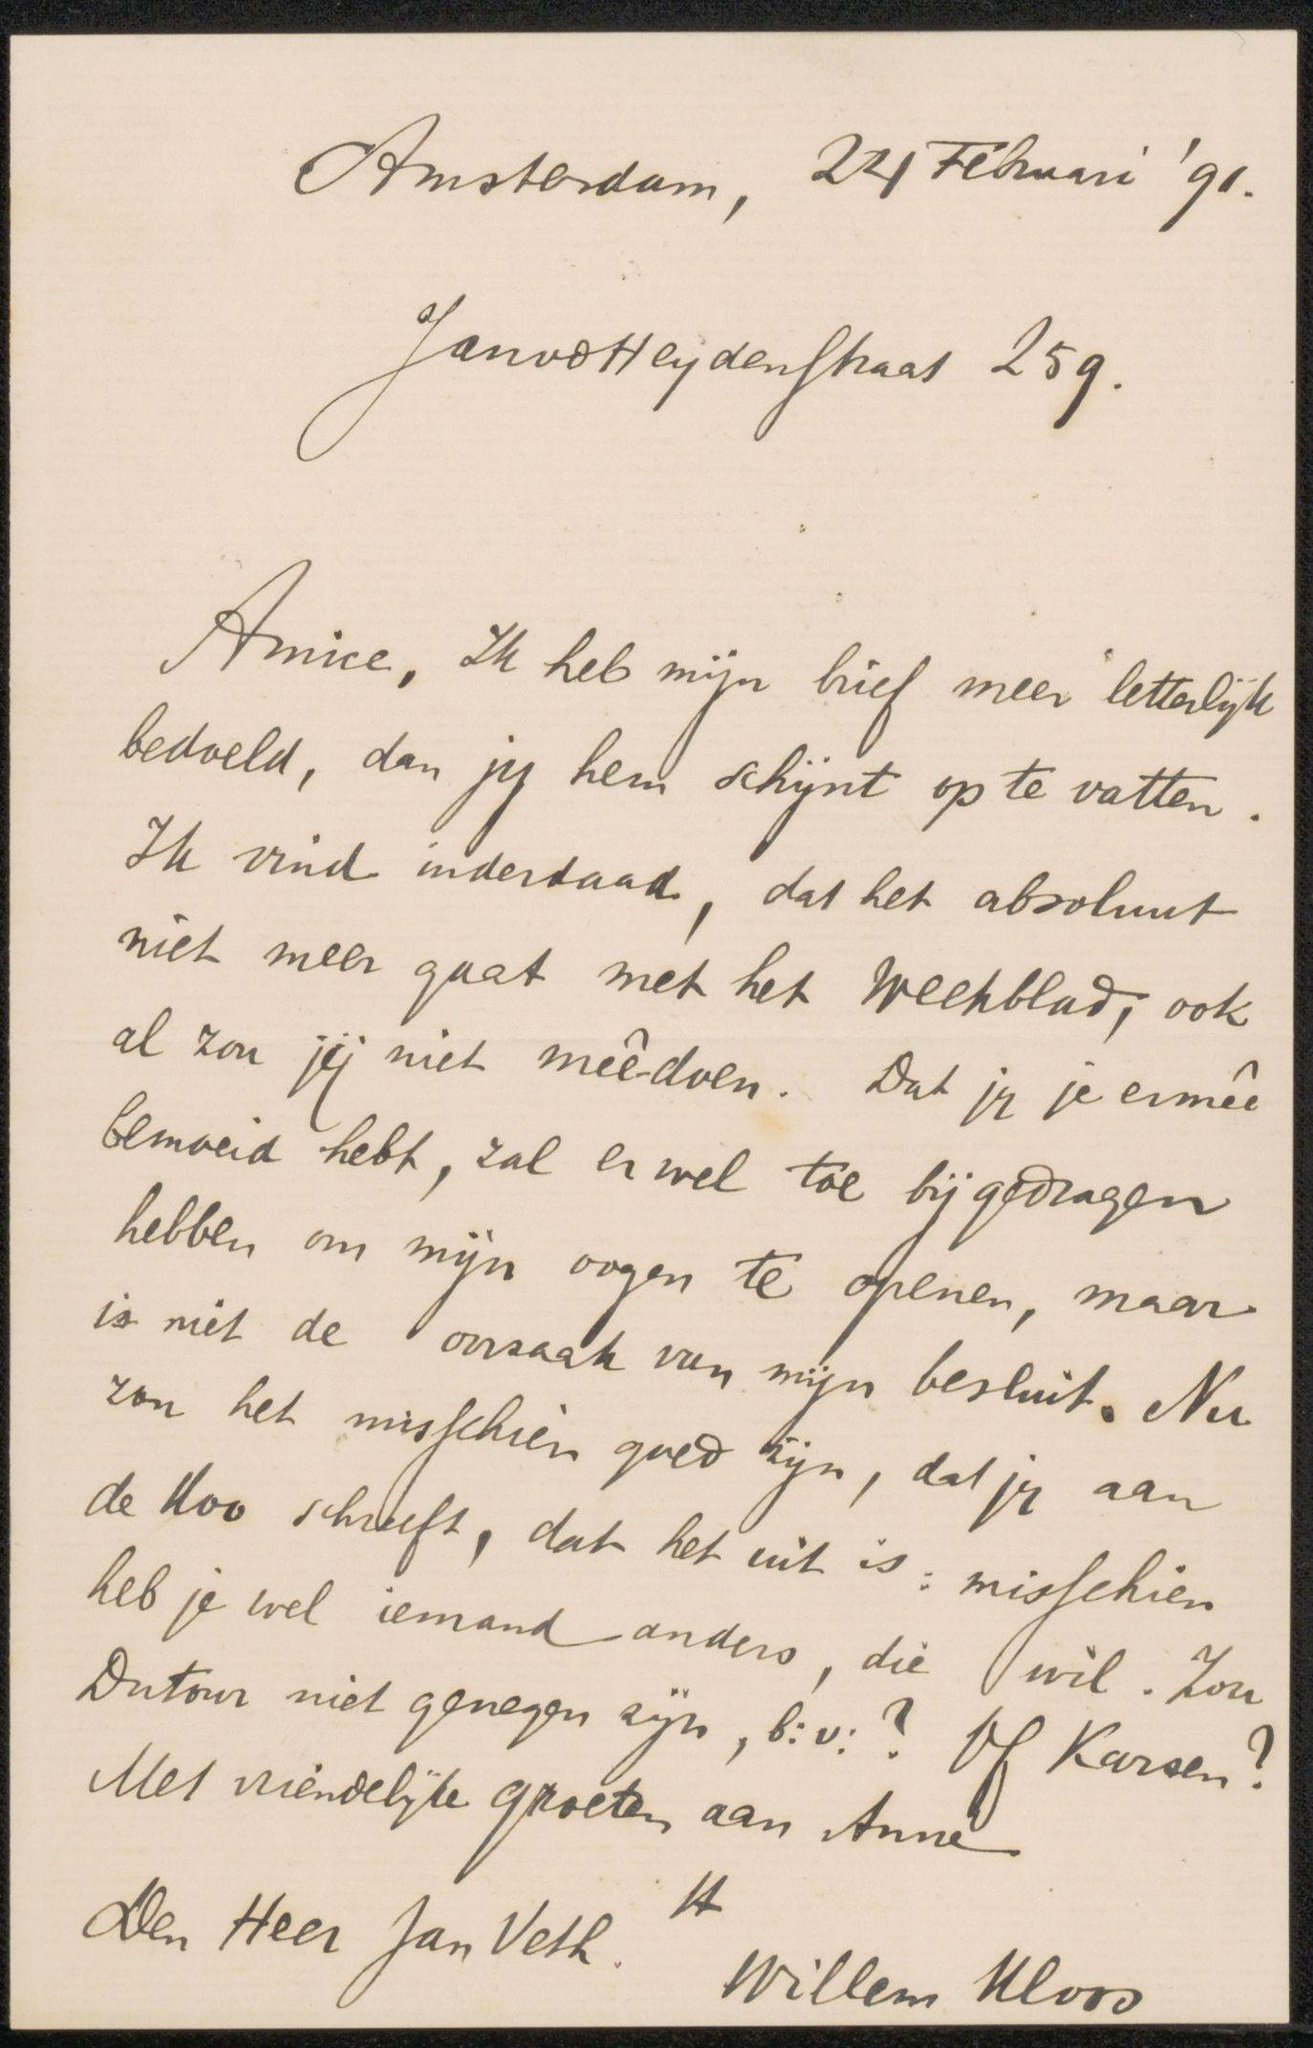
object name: letter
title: Brief aan Jan Veth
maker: willem kloos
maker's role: dichter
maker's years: 1859-1938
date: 1891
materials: ink, paper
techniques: pen, writing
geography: amsterdam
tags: dordrecht, painter, print maker, draughtsman, designer, jan veth, eduard karsen, richard nicolaüs roland holst, johannes de koo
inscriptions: collector's mark: ‘RPK’